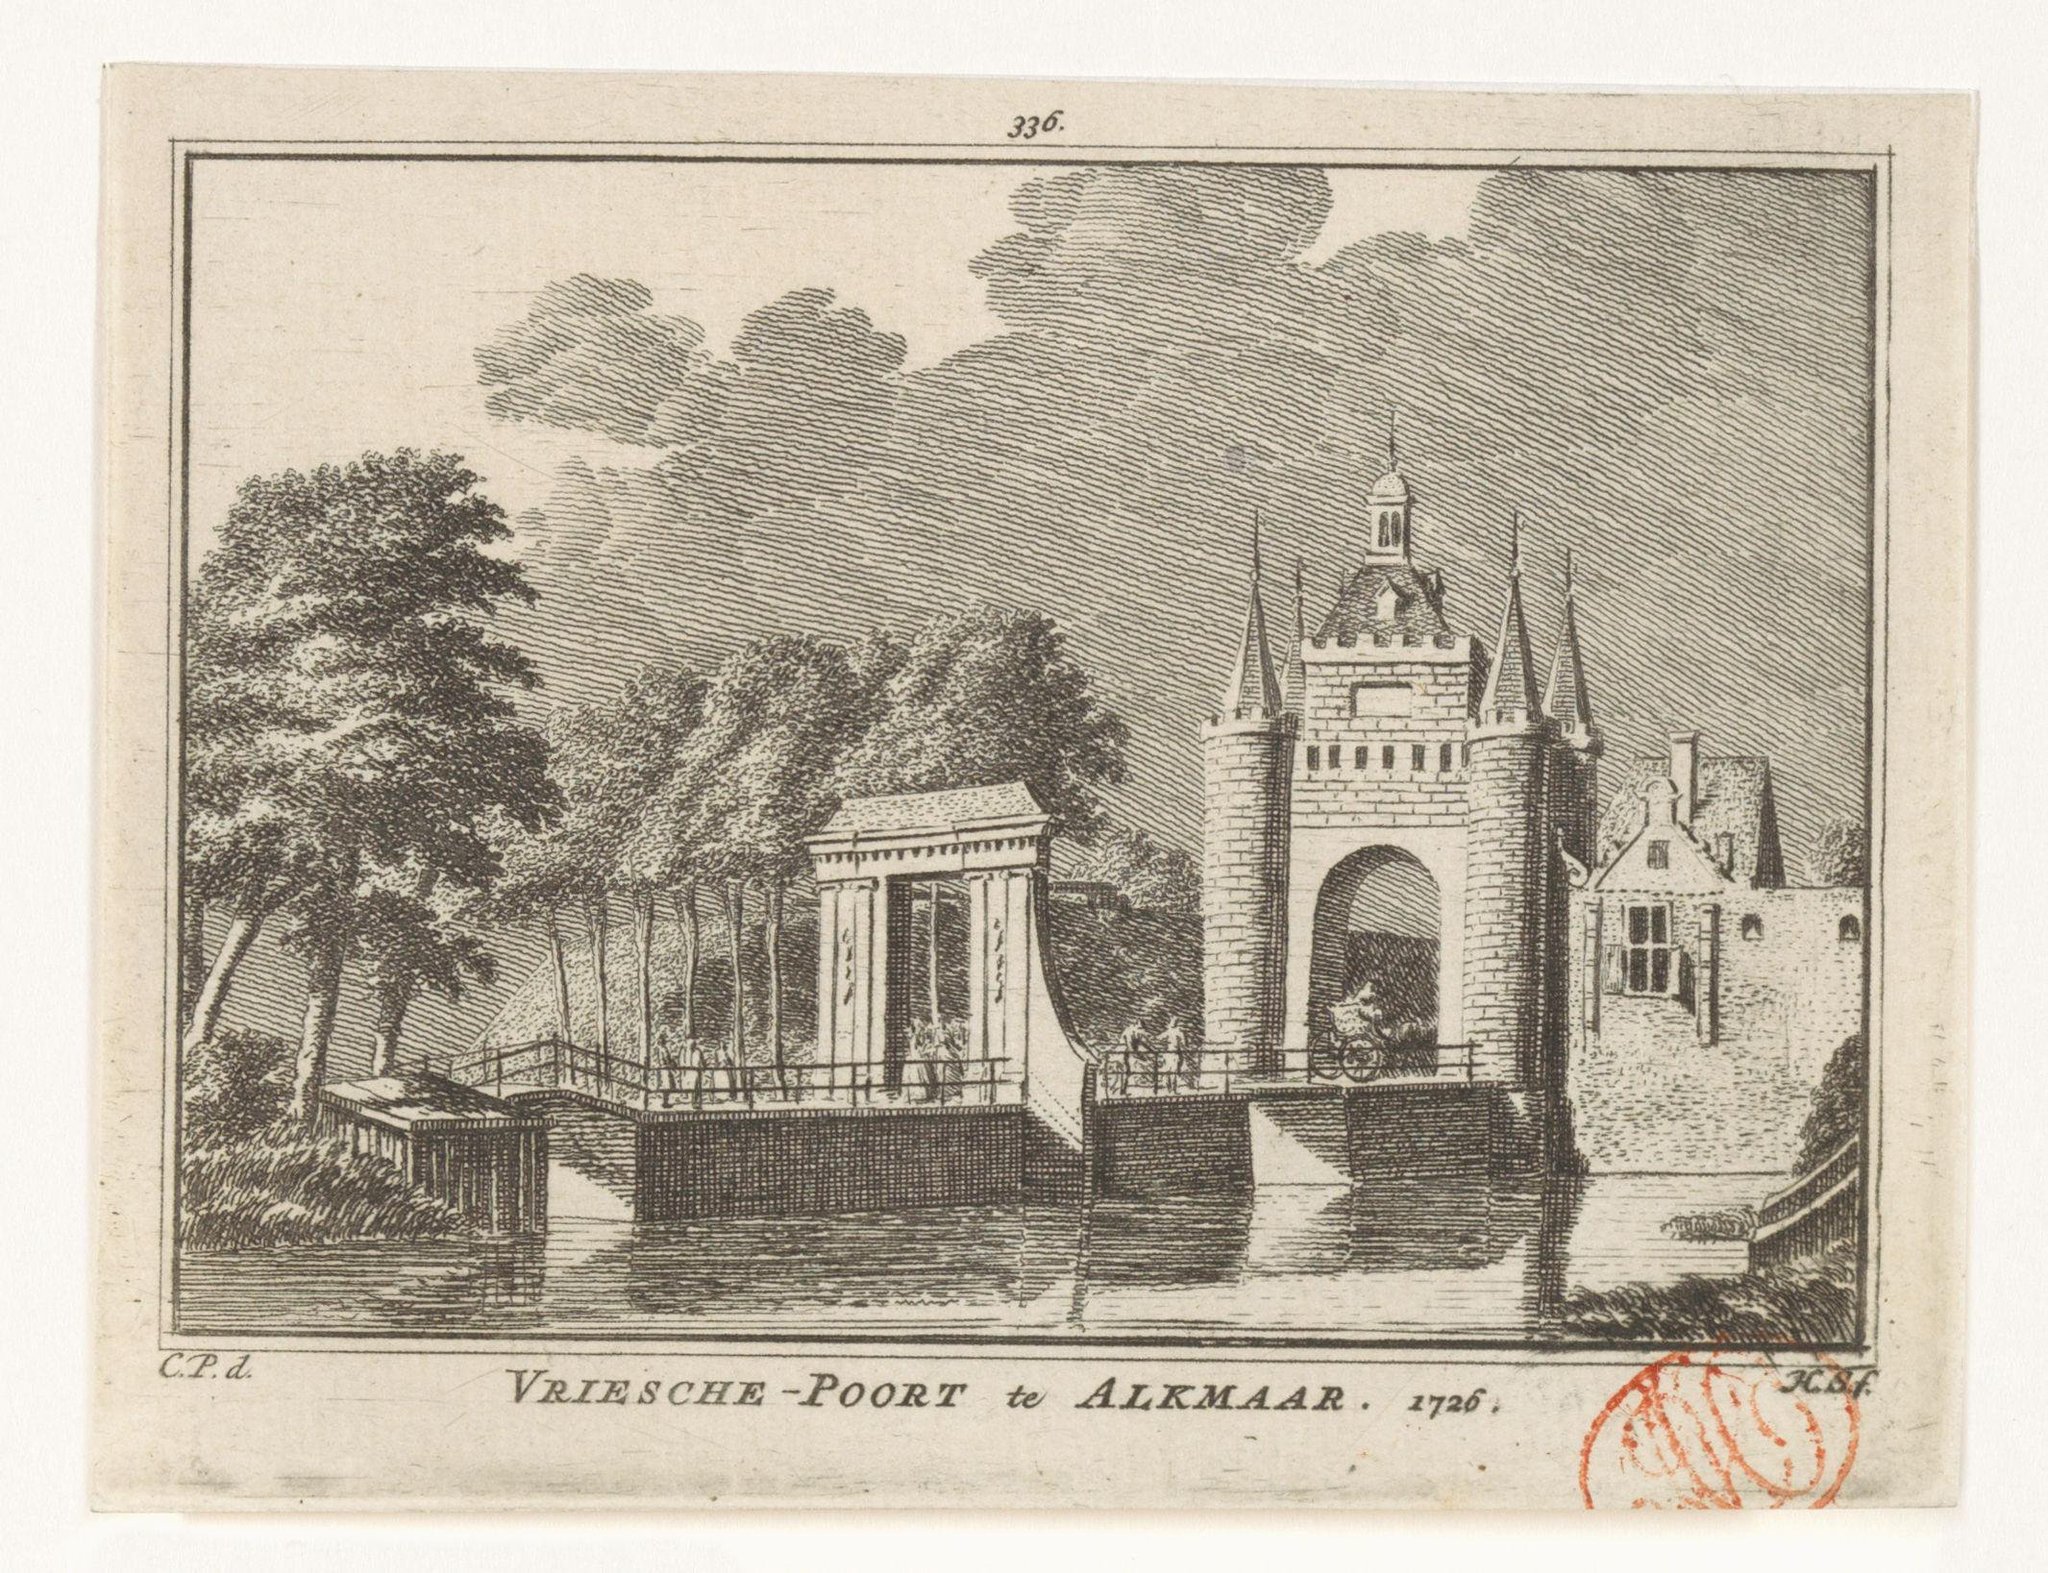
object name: print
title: Gezicht op de Friesepoort te Alkmaar, 1726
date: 1752-1792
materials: paper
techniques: engraving, etching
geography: haarlem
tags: bridge, city-gate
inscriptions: collector's mark: Lugt 195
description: Prent ook gebruikt in: Het verheerlykt Nederland of kabinet van hedendaagsche gezigten van steden, dorpen (…). 9 delen. Amsterdam: Isaak Tirion en weduwe Isaak Tirion, 1745-1774, dl. 4 (1752), ill. 336. Of in: Nederlandsche tafereelen; of eene keurige verzameling van negen honderd fraaije gezigten van steden, dorpen, sloten, oudheden (….). 9 delen. Amsterdam: Jan de Groot, 1792, dl. 4, ill. 336. Uit welke druk het huidige exemplaar precies komt is niet na te gaan.